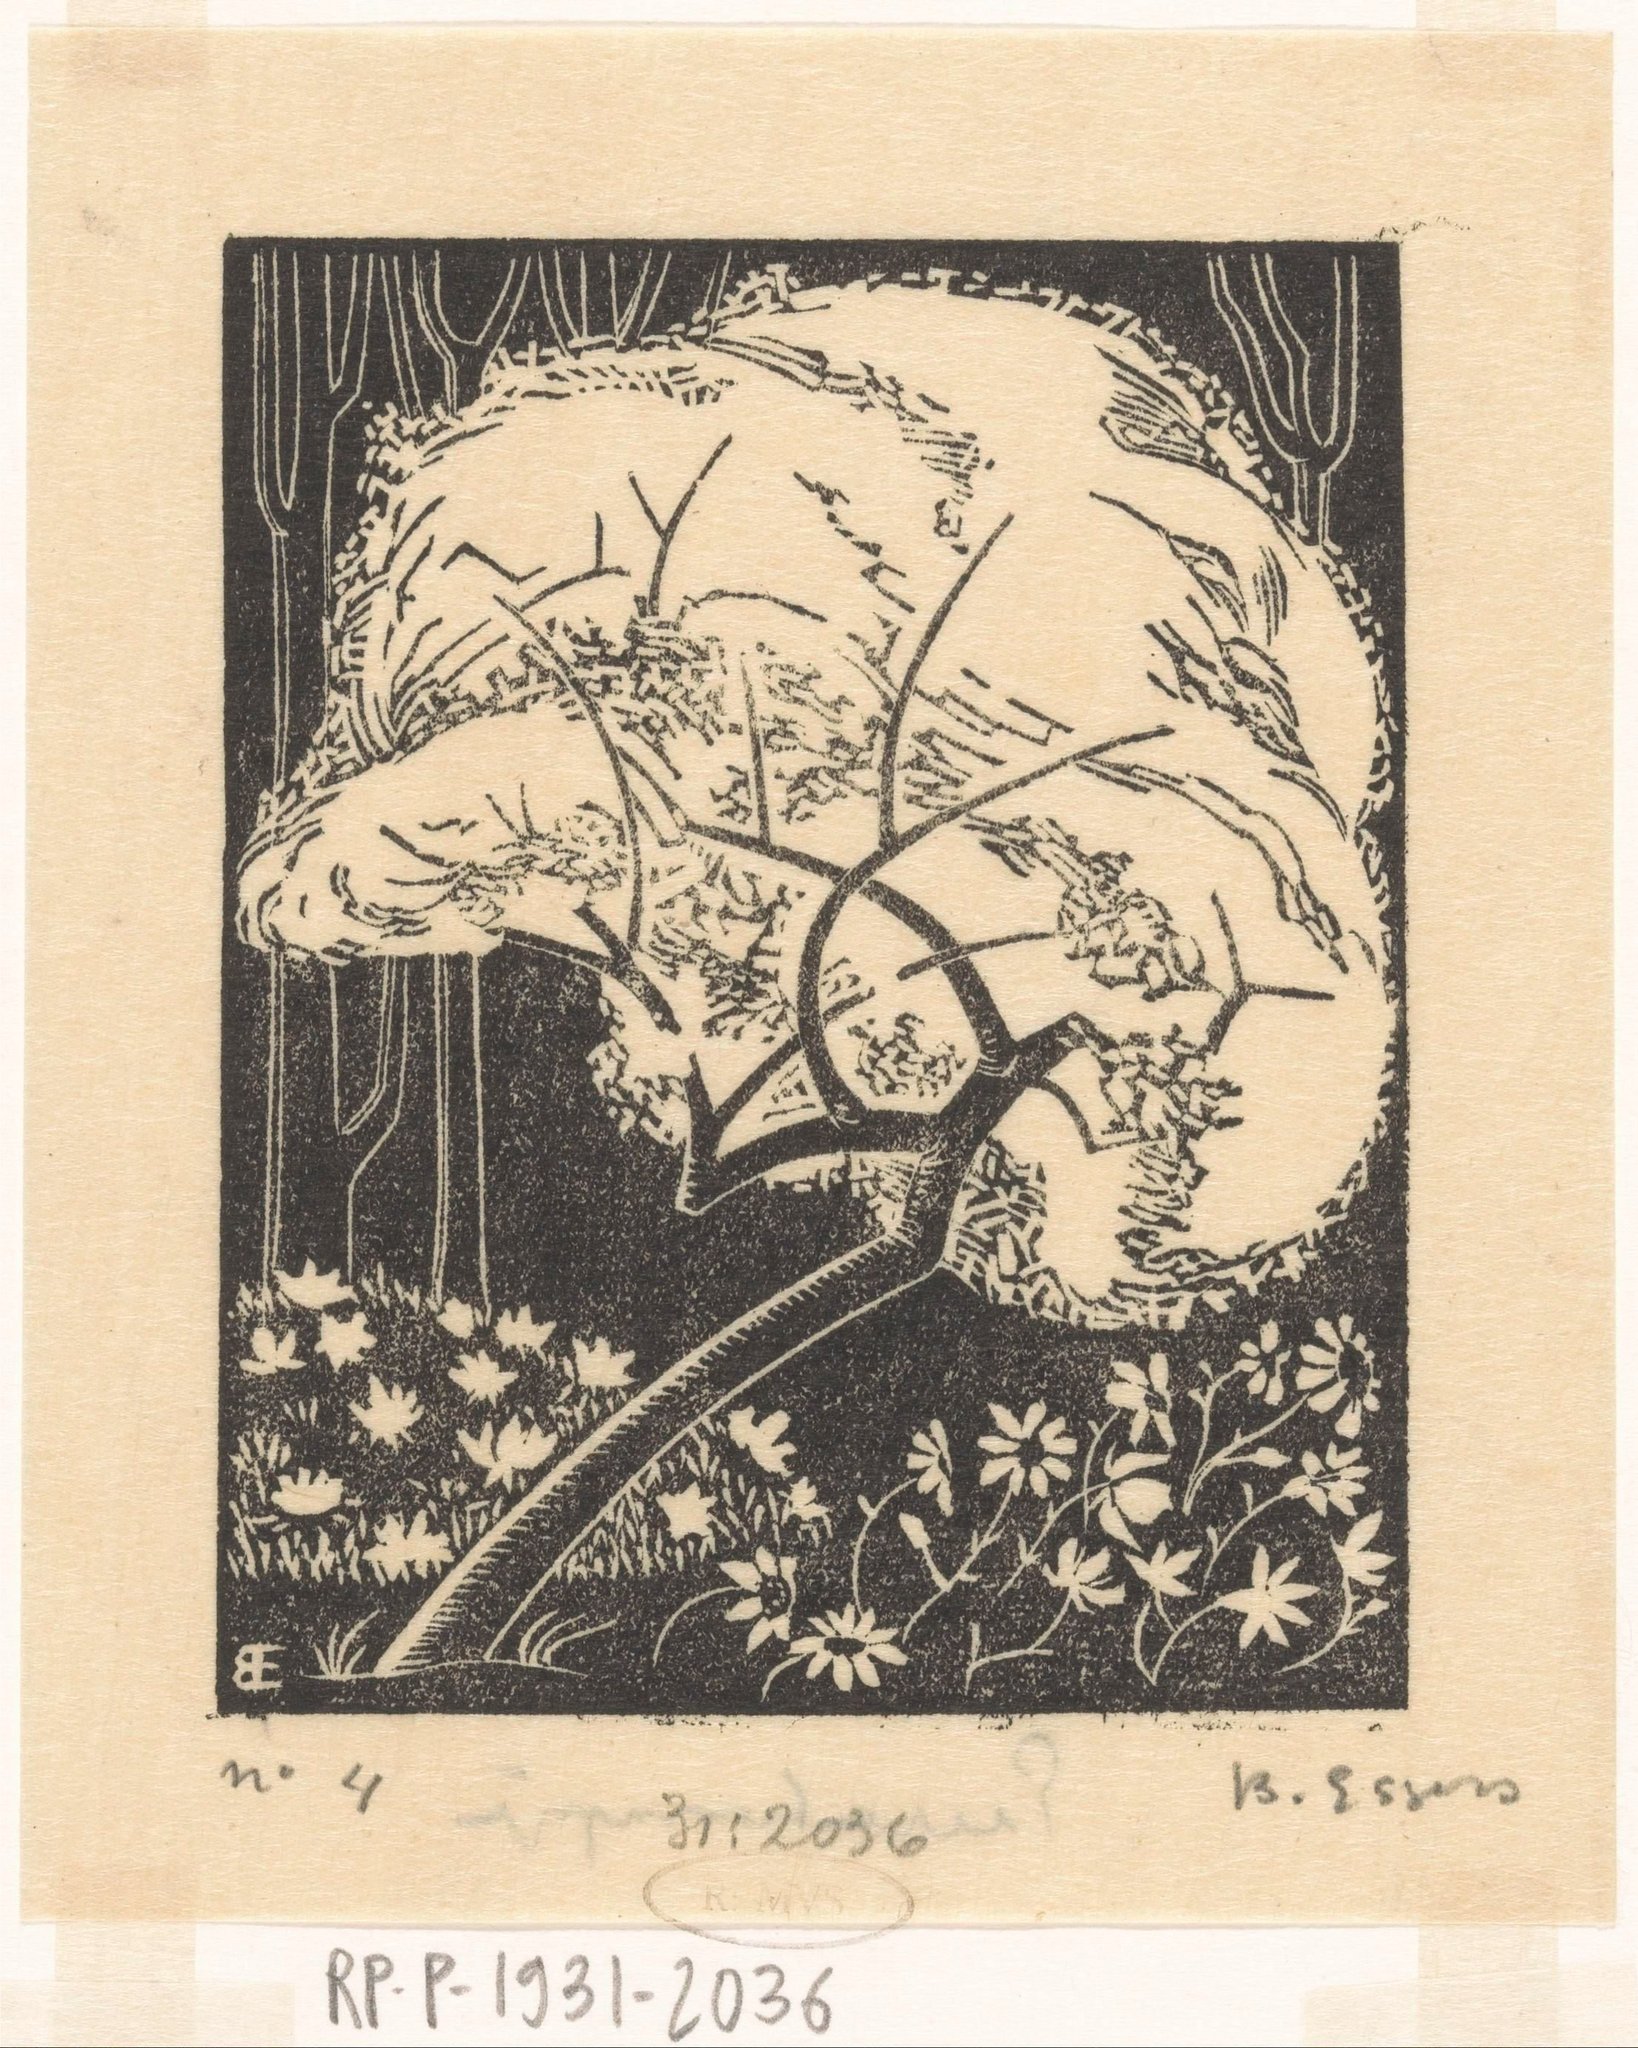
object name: book illustration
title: Le cinquième livre des stances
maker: bernard essers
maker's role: print maker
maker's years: 1893-1945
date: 1927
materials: paper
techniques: engraving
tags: flowers, trees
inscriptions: collector's mark: Lugt 2228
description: Prent gebruikt voor: Moréas, Jean. Les Stances. Parijs: Connaissance, 1927.